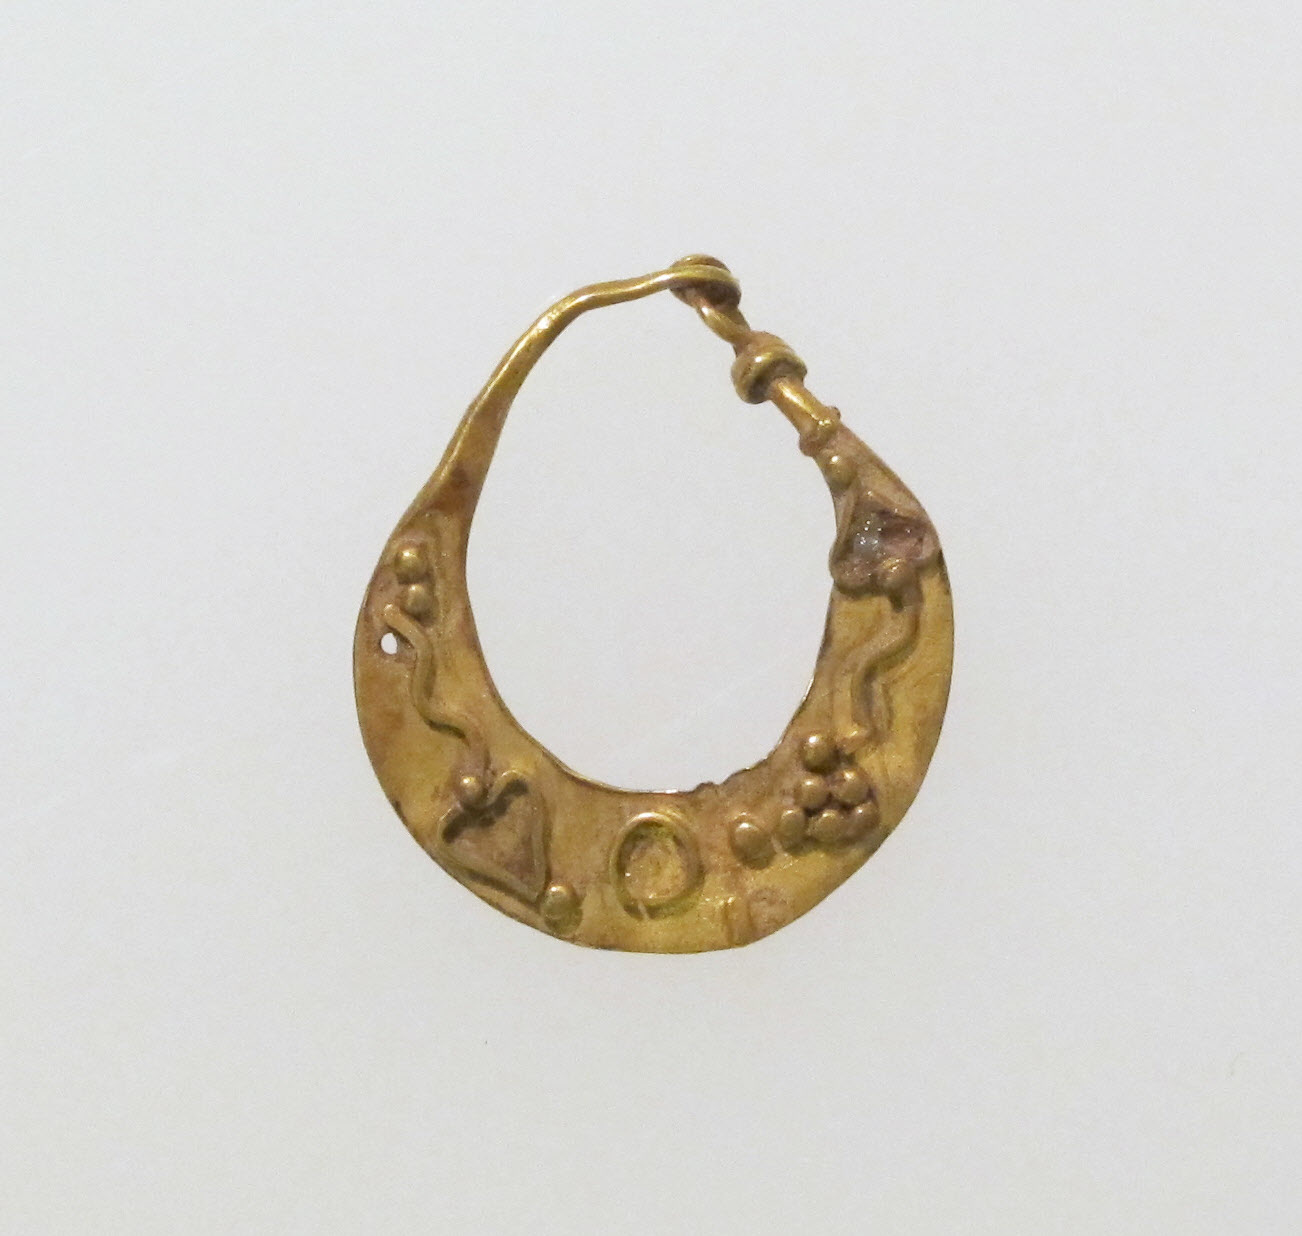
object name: earring, crescent shaped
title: Earring, crescent-shaped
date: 7000 BCE-330 CE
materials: gold